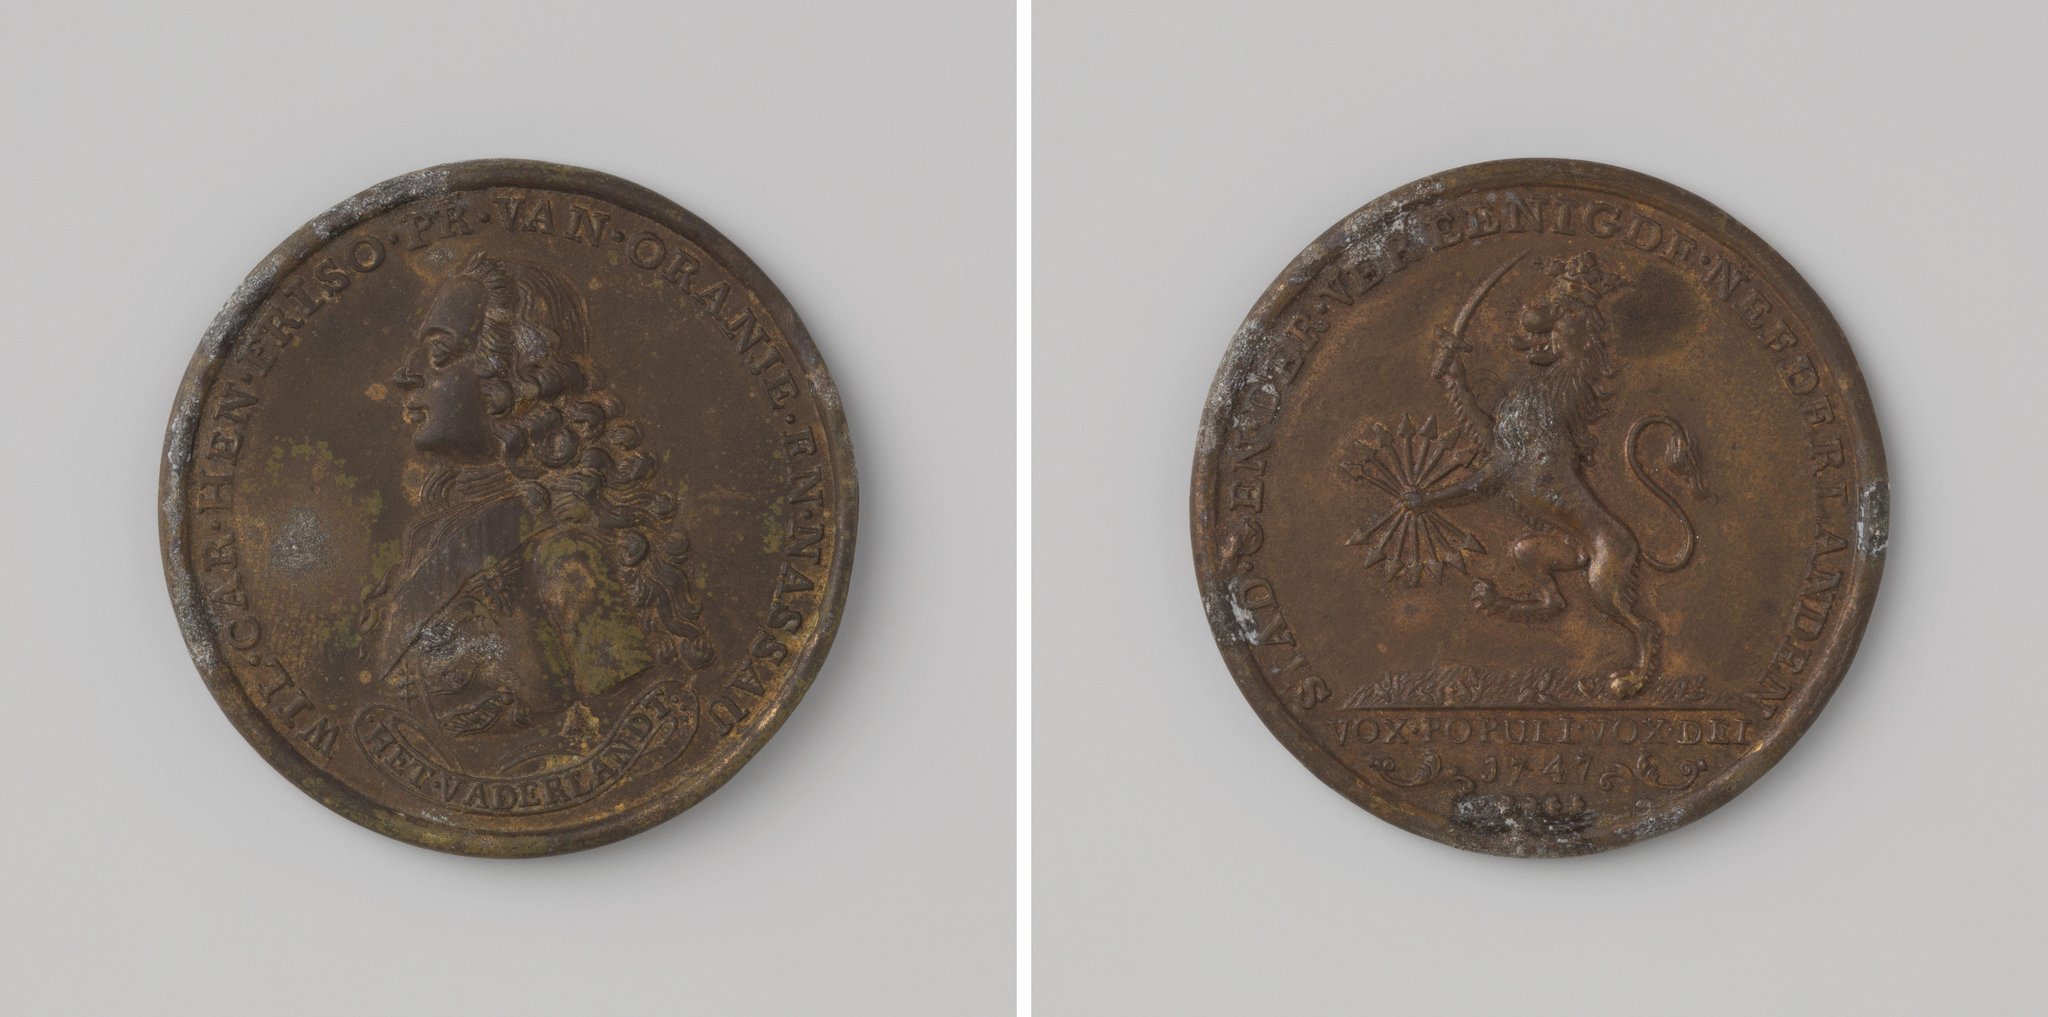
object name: history medal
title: Verheffing van Willem IV, prins van Oranje-Nassau, tot admiraal en kapitein-generaal der Verenigde Nederlanden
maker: Anonymous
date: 1747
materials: copper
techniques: striking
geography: netherlands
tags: the hague, willem iv (prins van oranje-nassau)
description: Koperen penning. Voorzijde: borststuk man naar links binnen omschrift. Keerzijde: gekroonde leeuw met zwaard in geheven rechter- en bundel met zeven pijlen in linkerpoot binnen omschrift; afsnede: opschrift